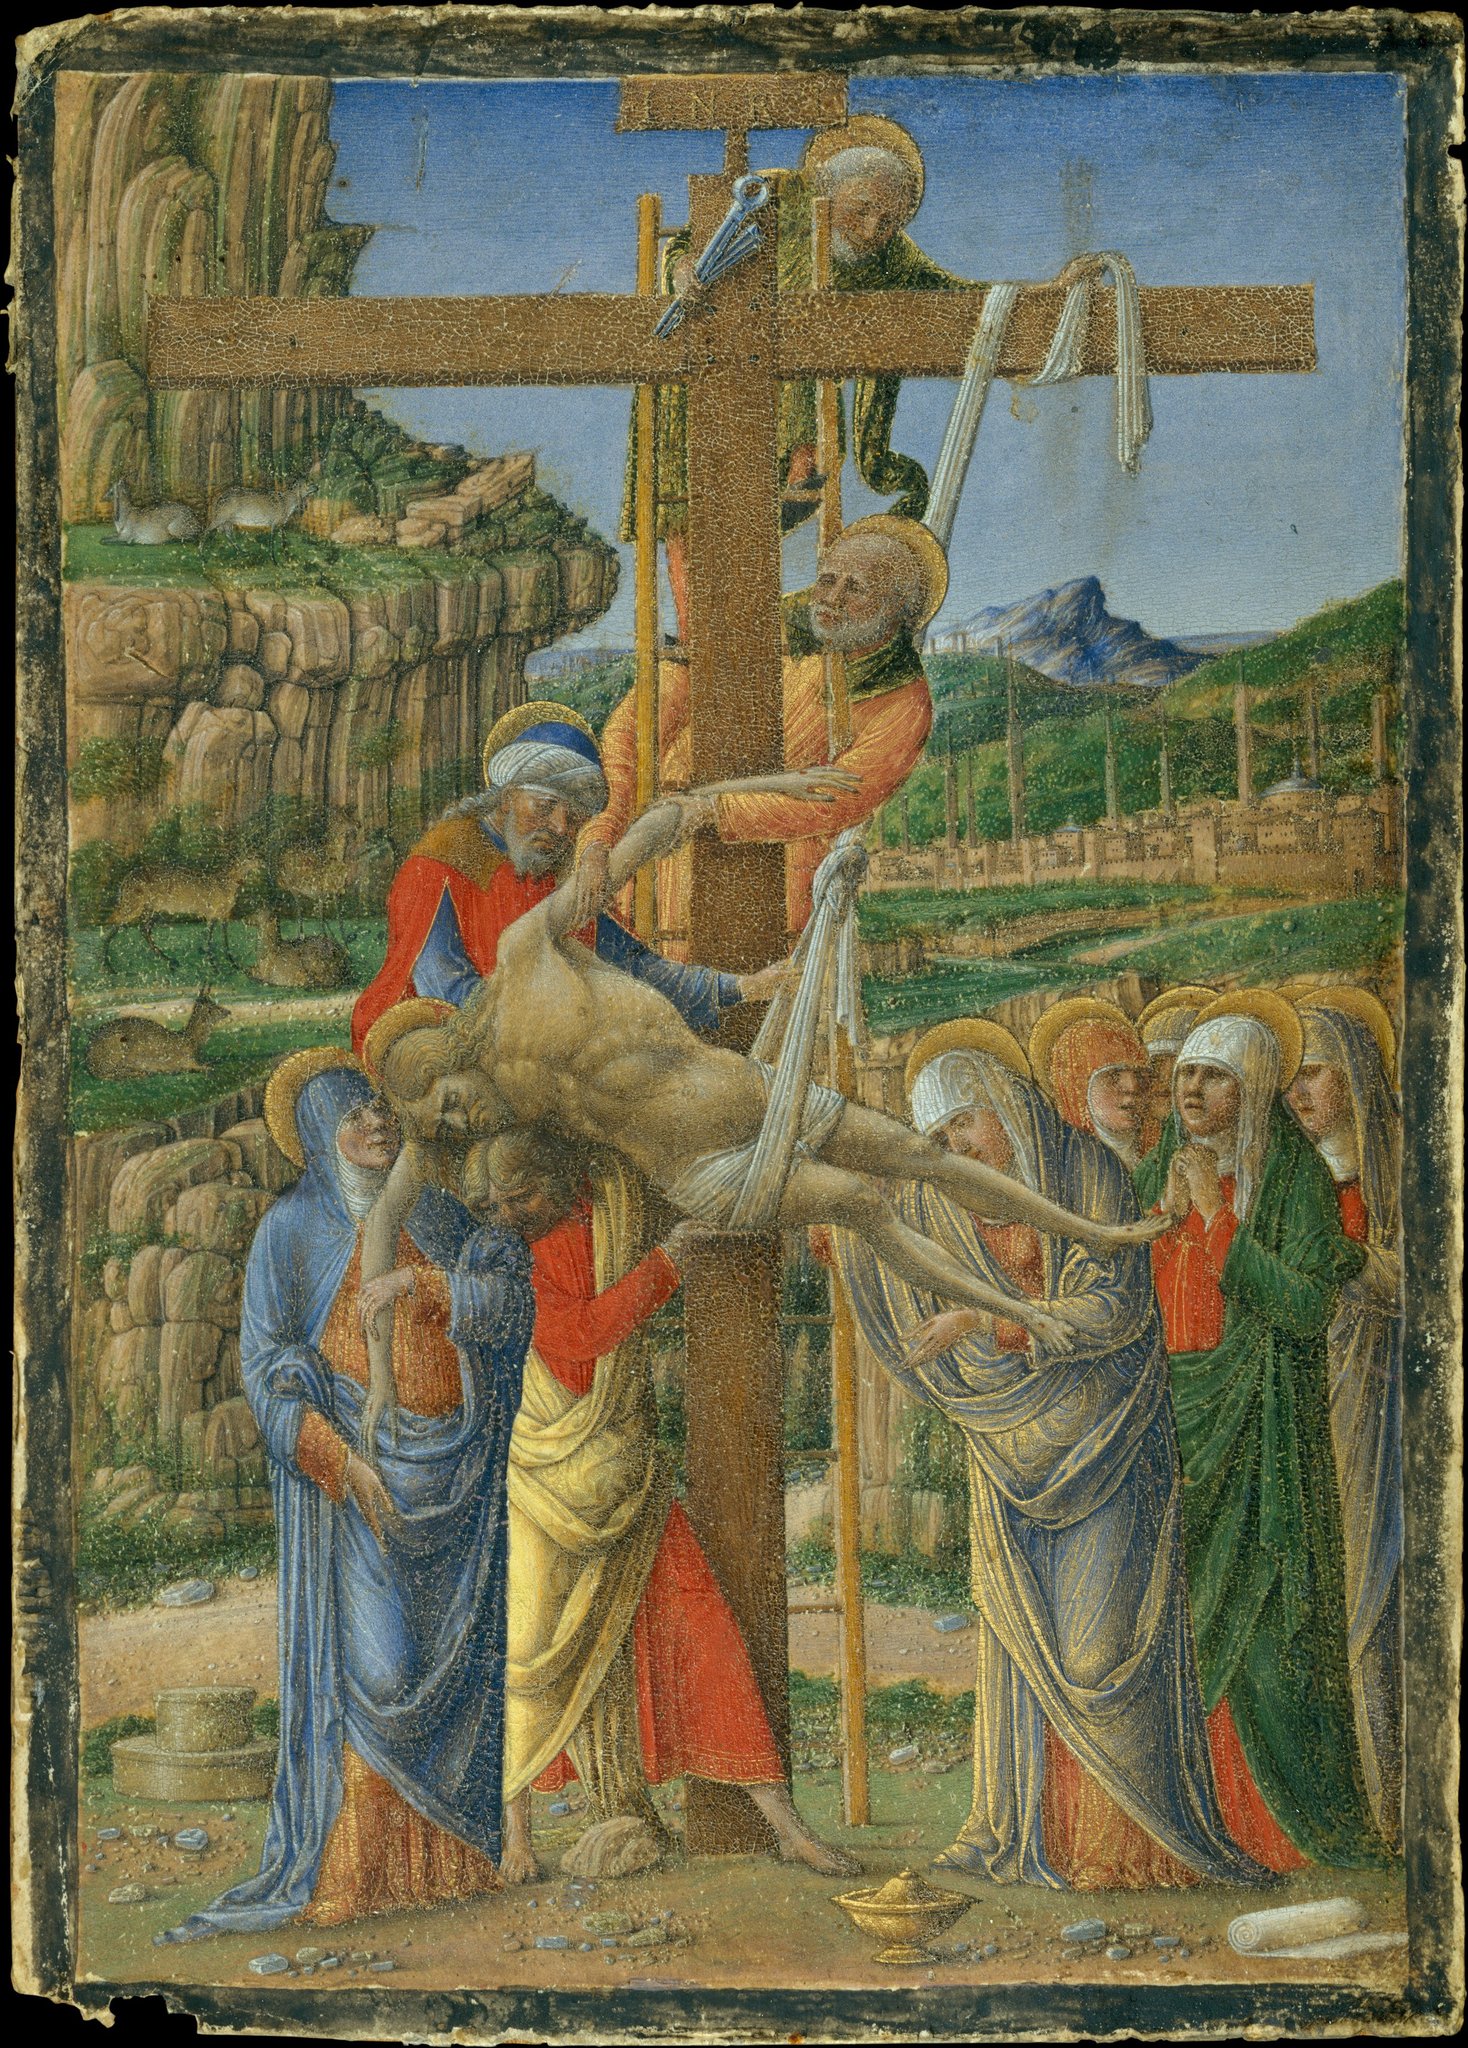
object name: painting, drawing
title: Descent from the Cross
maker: girolamo da cremona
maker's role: artist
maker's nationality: italian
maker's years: 1451-1481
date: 1451-1483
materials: parchment, paint, wood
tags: christ,mary magdalene,saint john the evangelist,descent from the cross